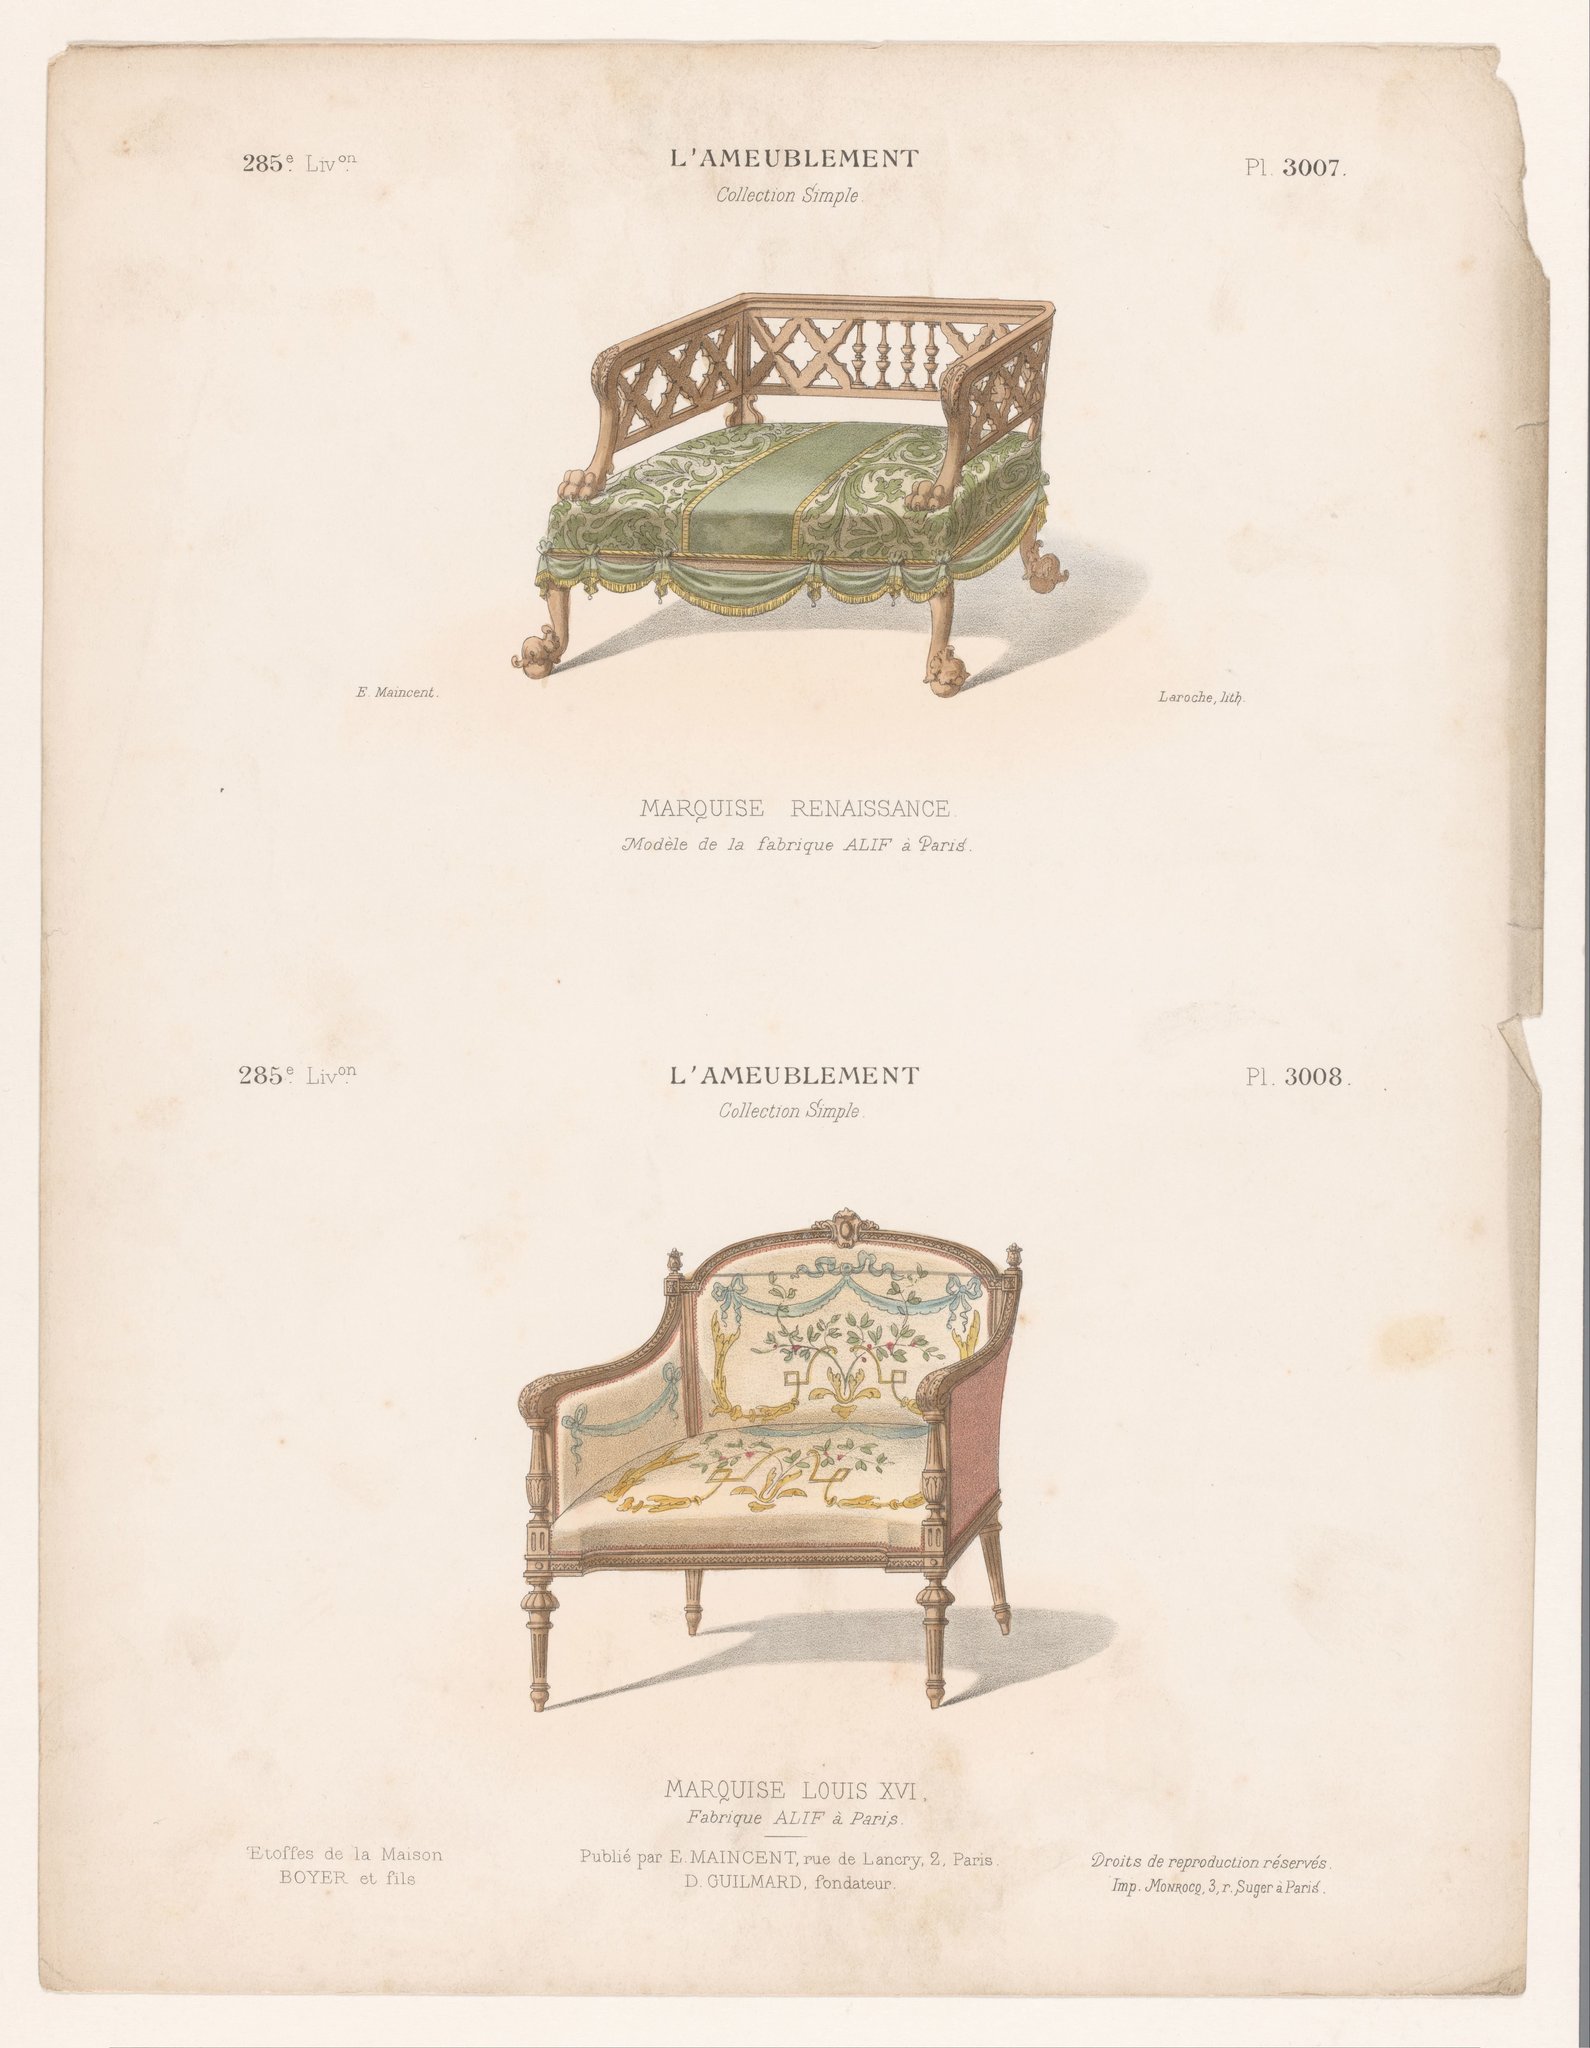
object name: print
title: Twee stoelen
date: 1885-1895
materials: paper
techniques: hand coloring, lithograph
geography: paris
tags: seating furniture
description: Twee stoelen in de stijlen van de renaissance en Lodewijk XVI. Prent uit 285e Livraison.